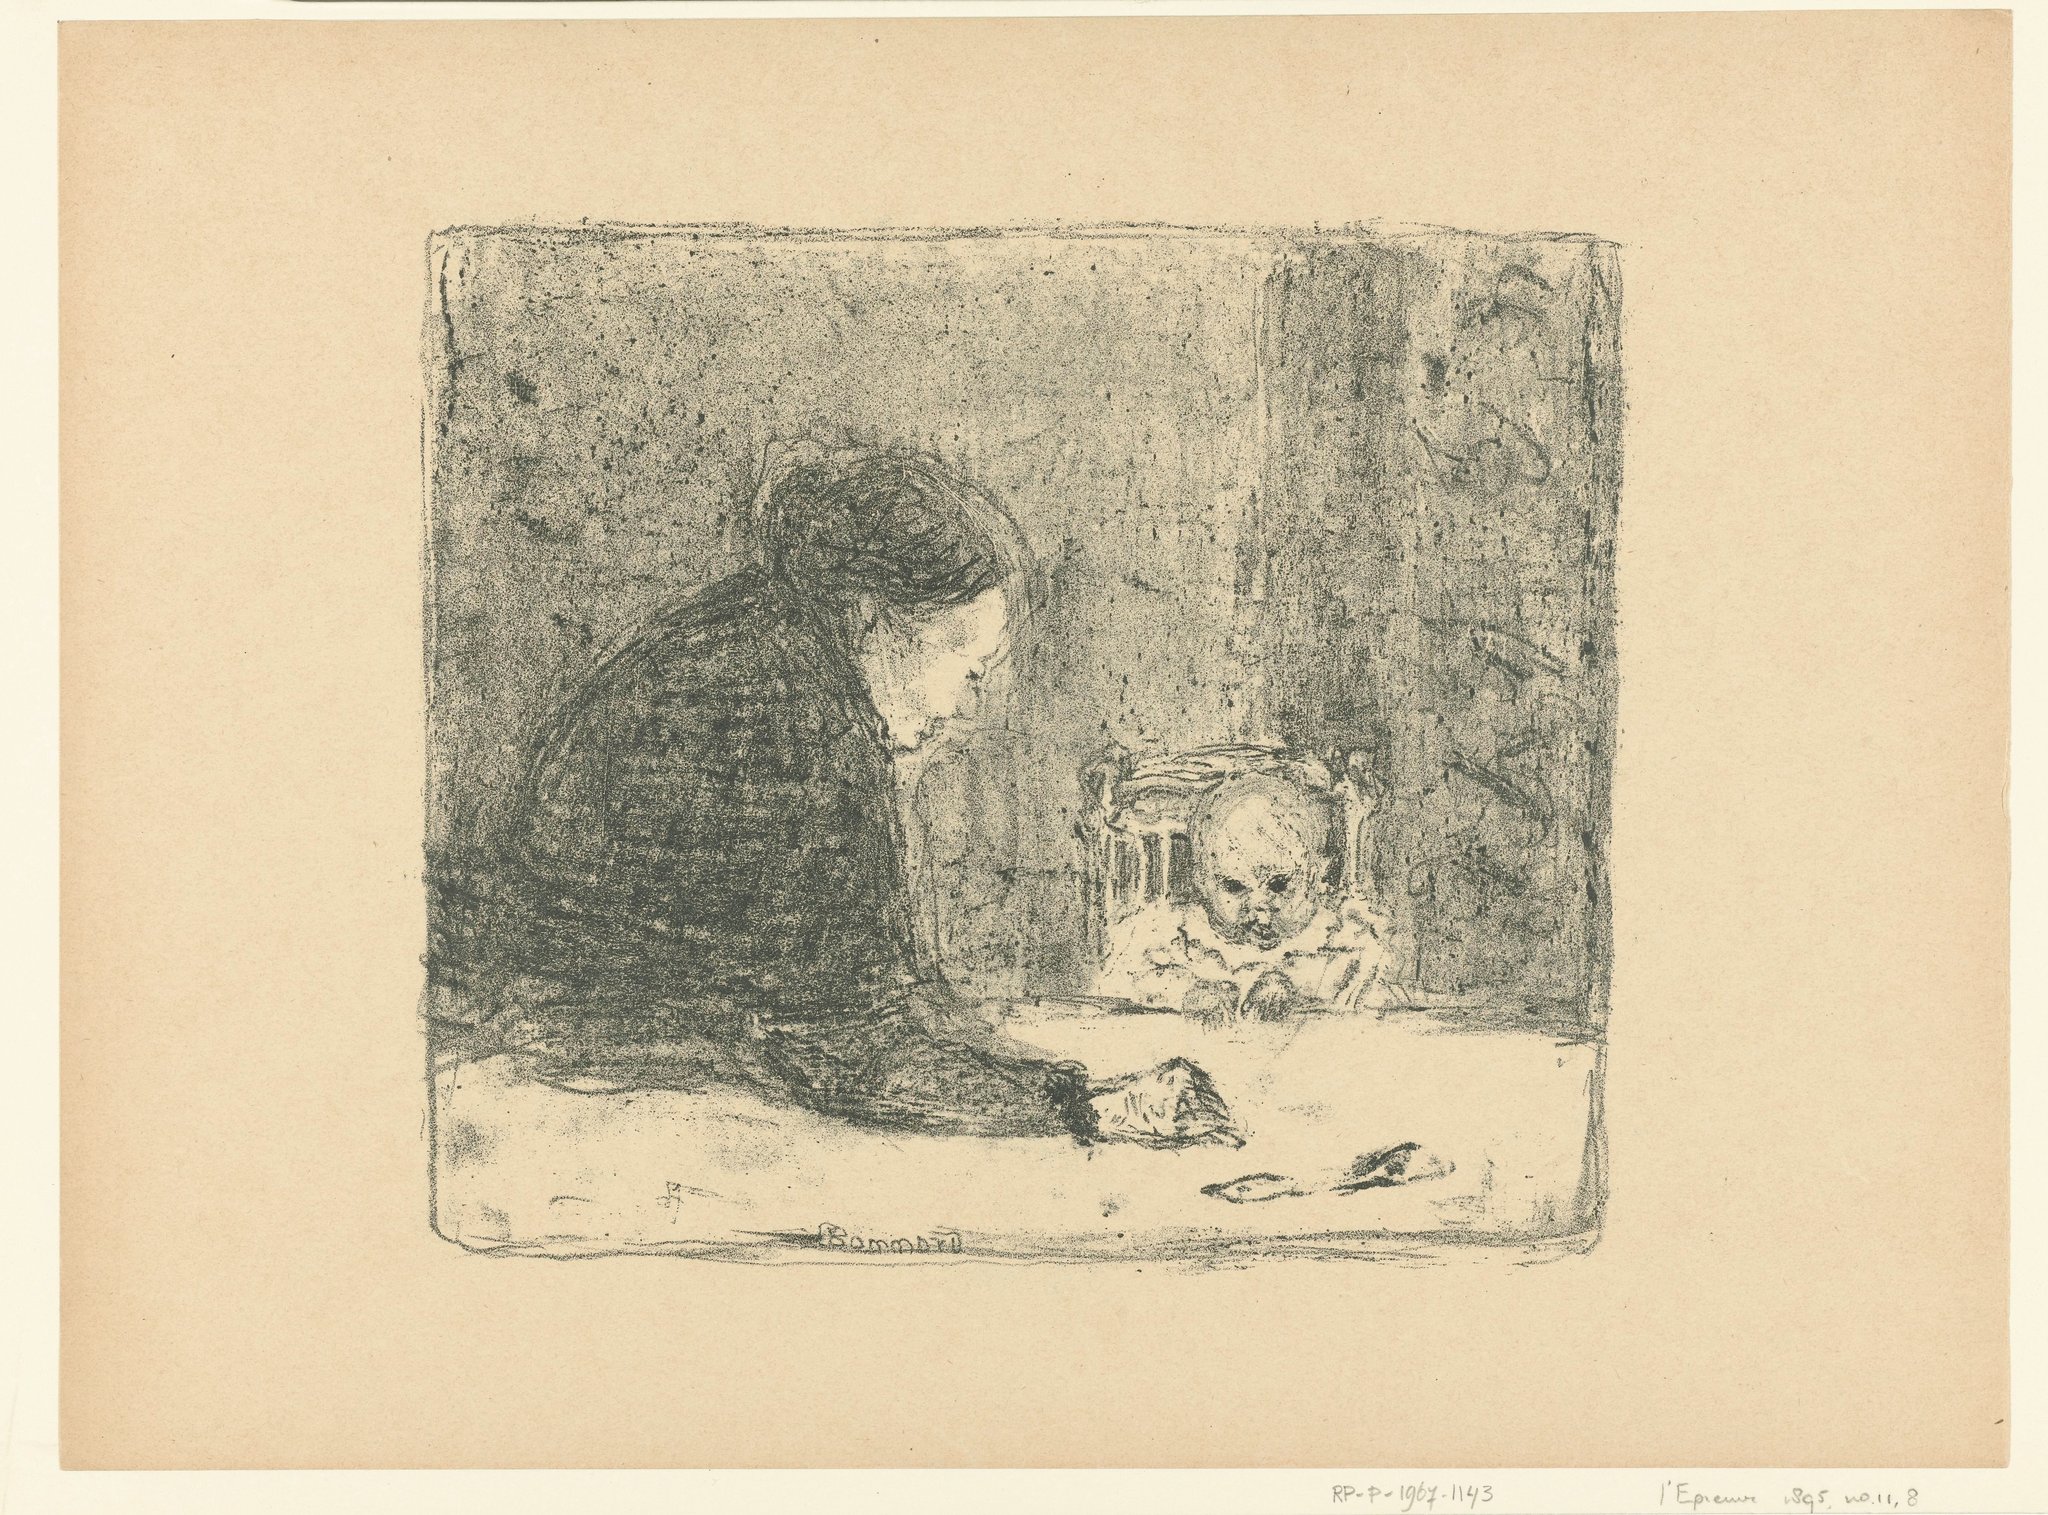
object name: print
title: Intérieur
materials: paper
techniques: lithograph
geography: paris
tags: child, grandparent(s) with grandchild(ren) (family group)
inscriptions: collector's mark: Lugt 2228, collector's mark: Lugt 2760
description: Verschenen in album met tien originele prenten als supplement bij tijdschrift: L'Epreuve, editie nr. 11, 1895, prent nr. 8